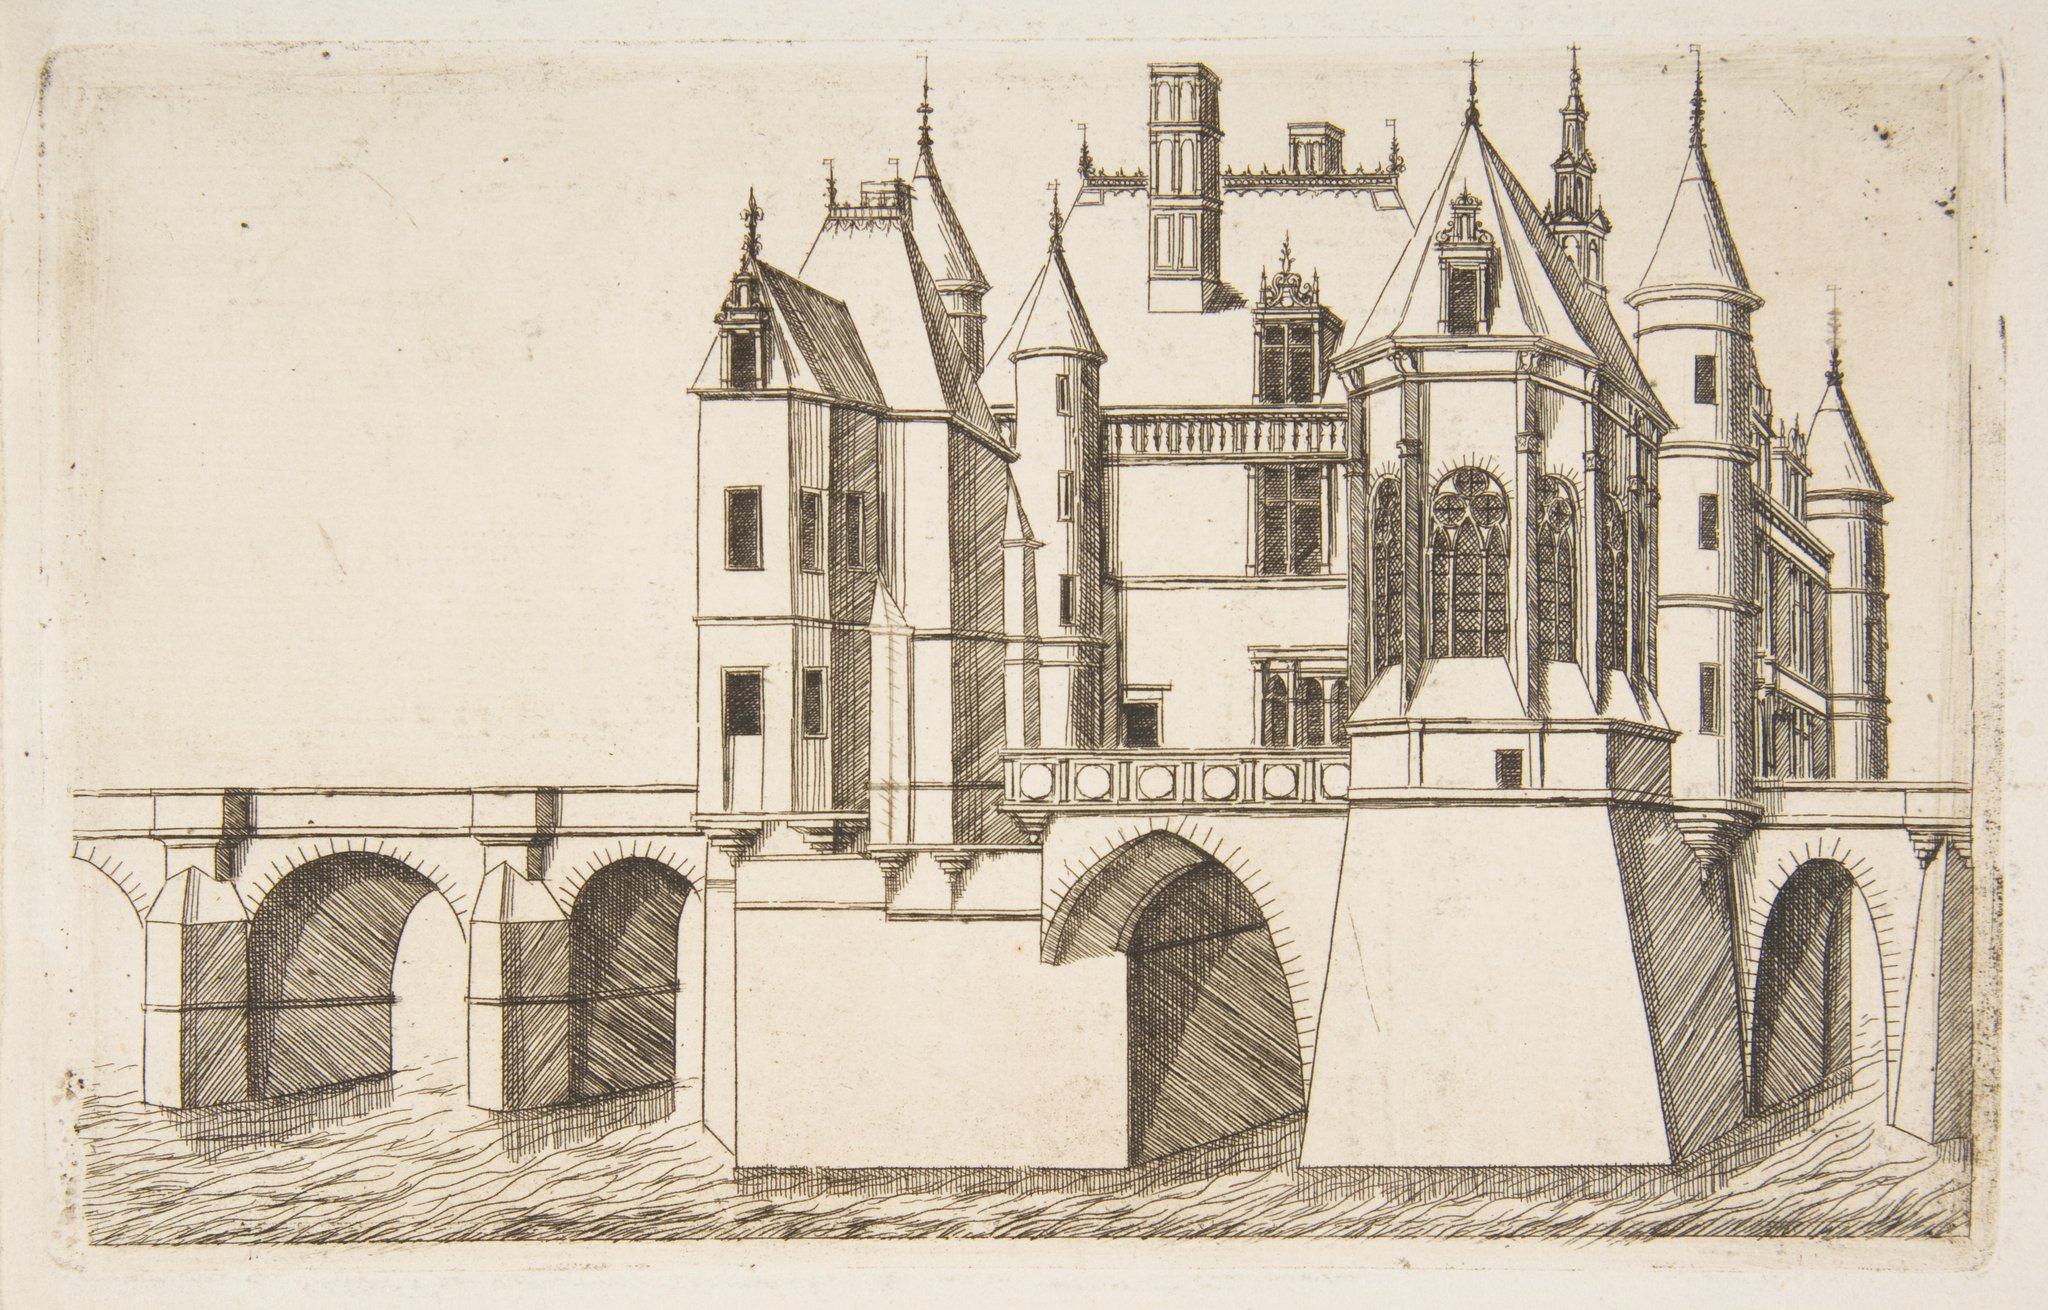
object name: print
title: Château de Chenonceau, No 2 (Château de Chenonceau, No 2)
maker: charles meryon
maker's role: artist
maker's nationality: french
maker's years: 1821-1868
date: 1856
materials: paper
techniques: etching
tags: buildings,bridges